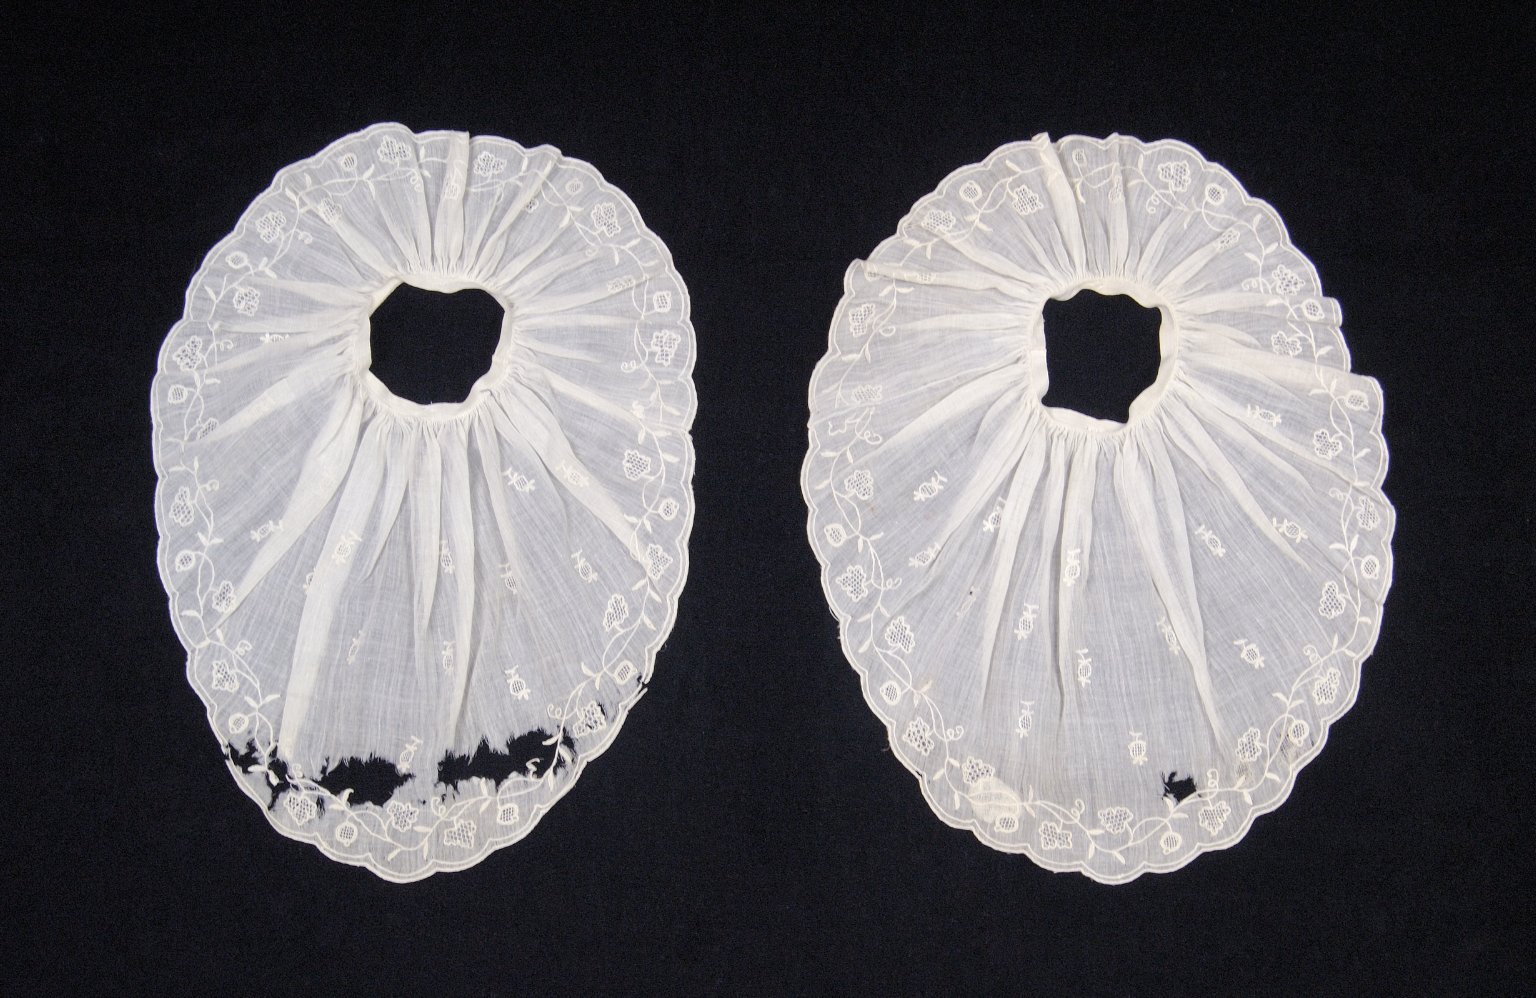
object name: engageantes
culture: british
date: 1760-1780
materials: cotton